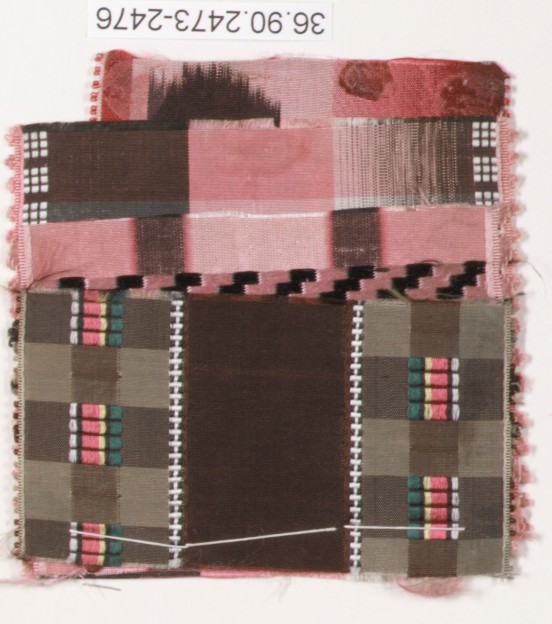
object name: ribbon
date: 1801-1900